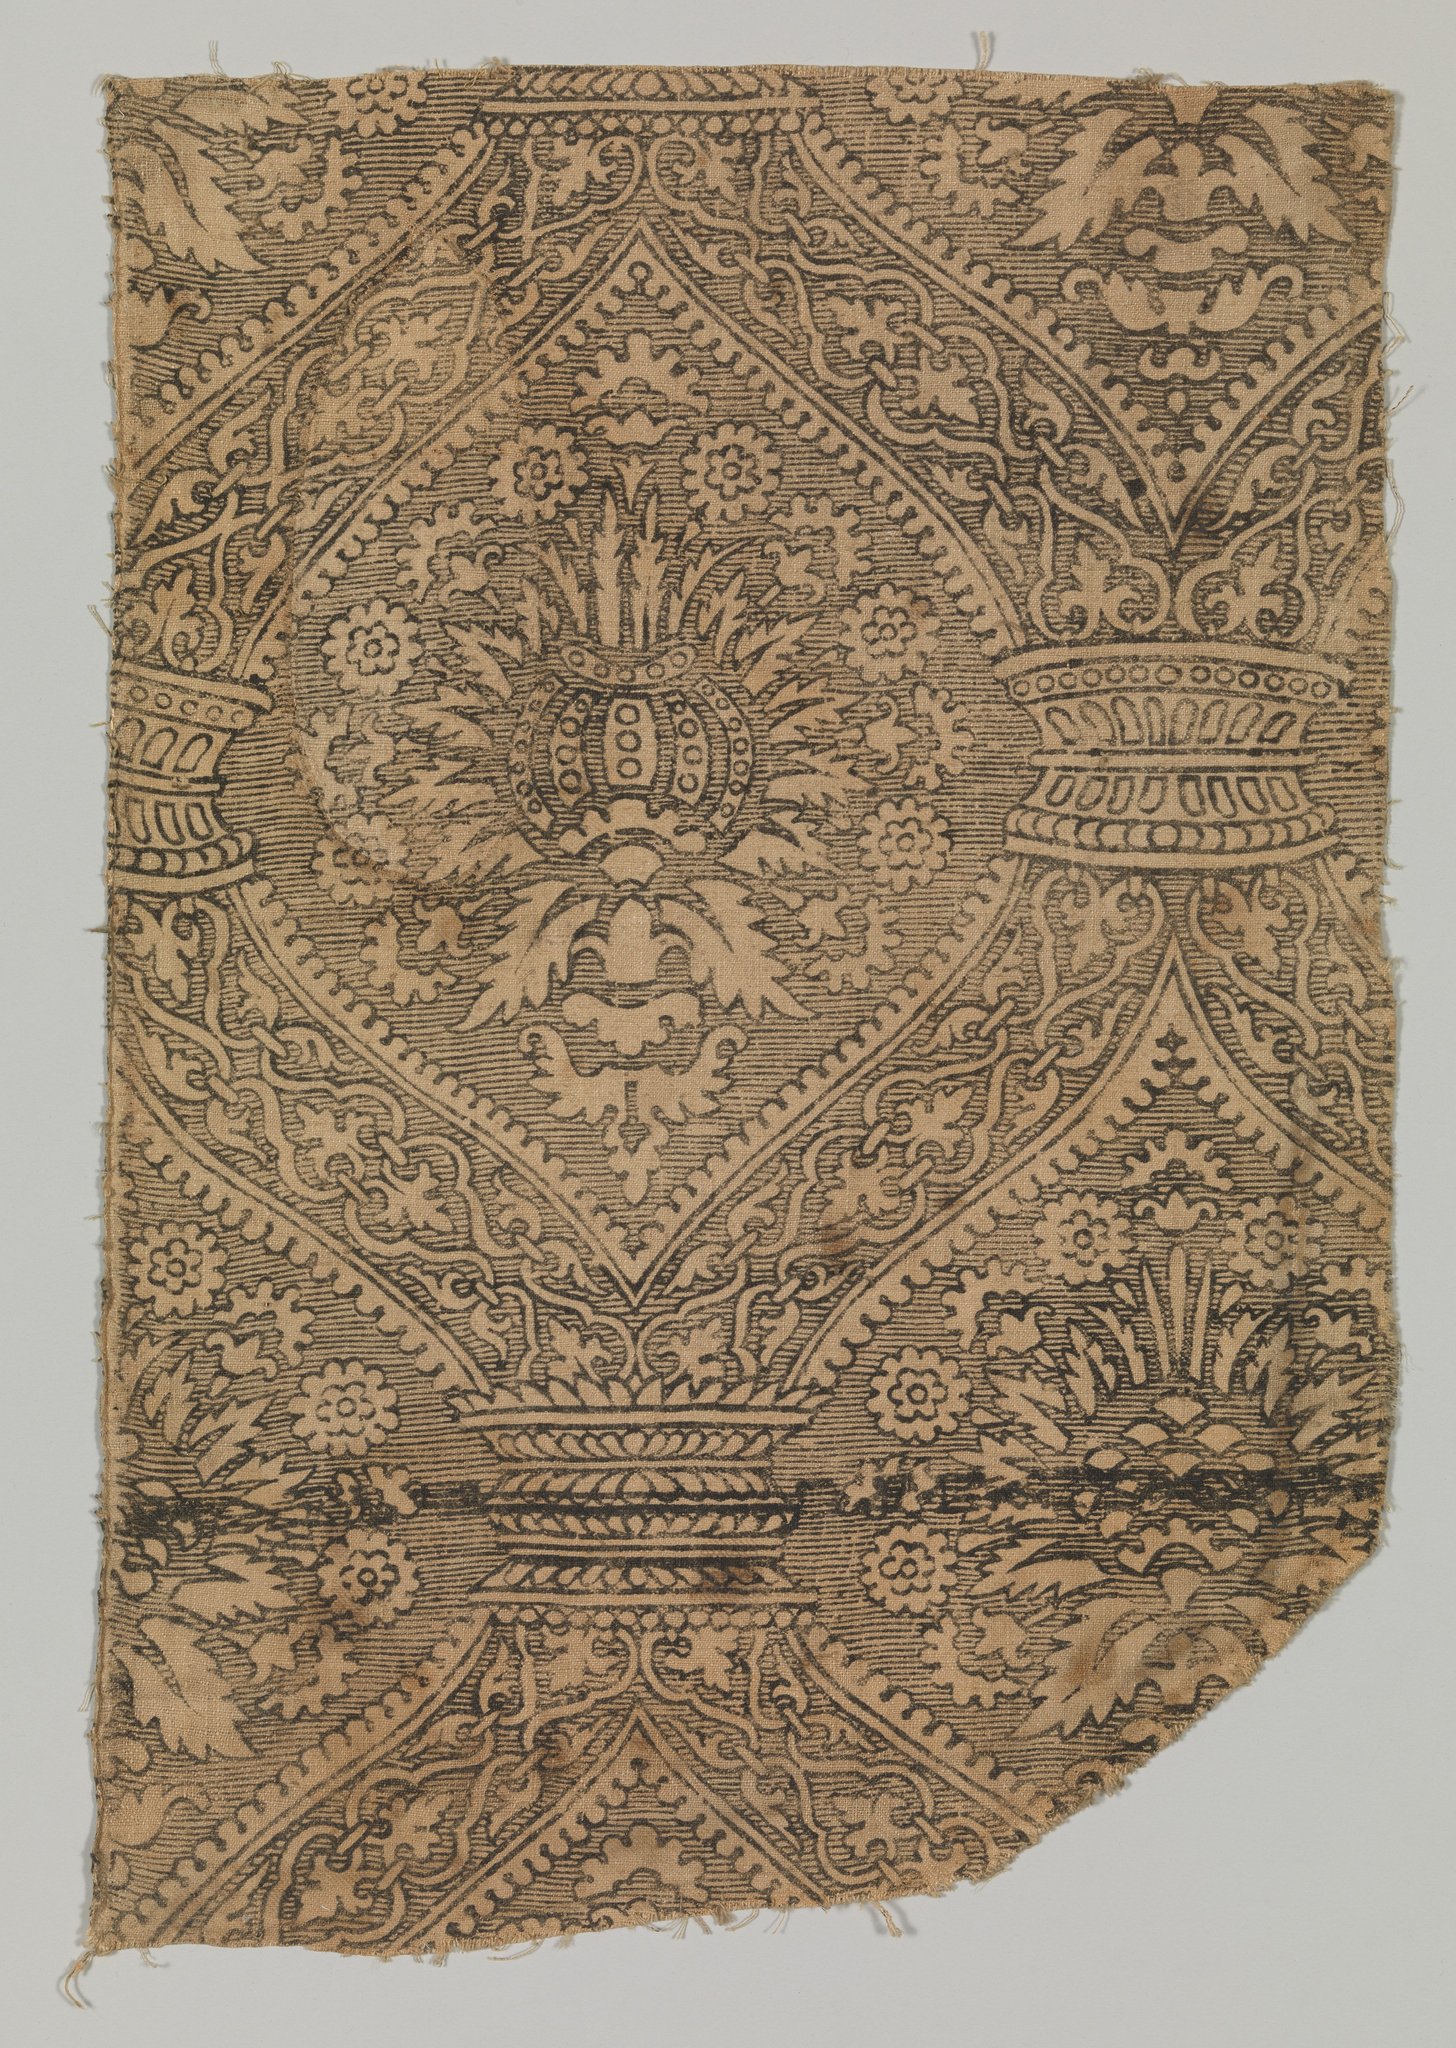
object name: fragment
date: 1401-1600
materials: cotton, linen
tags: flowers,leaves